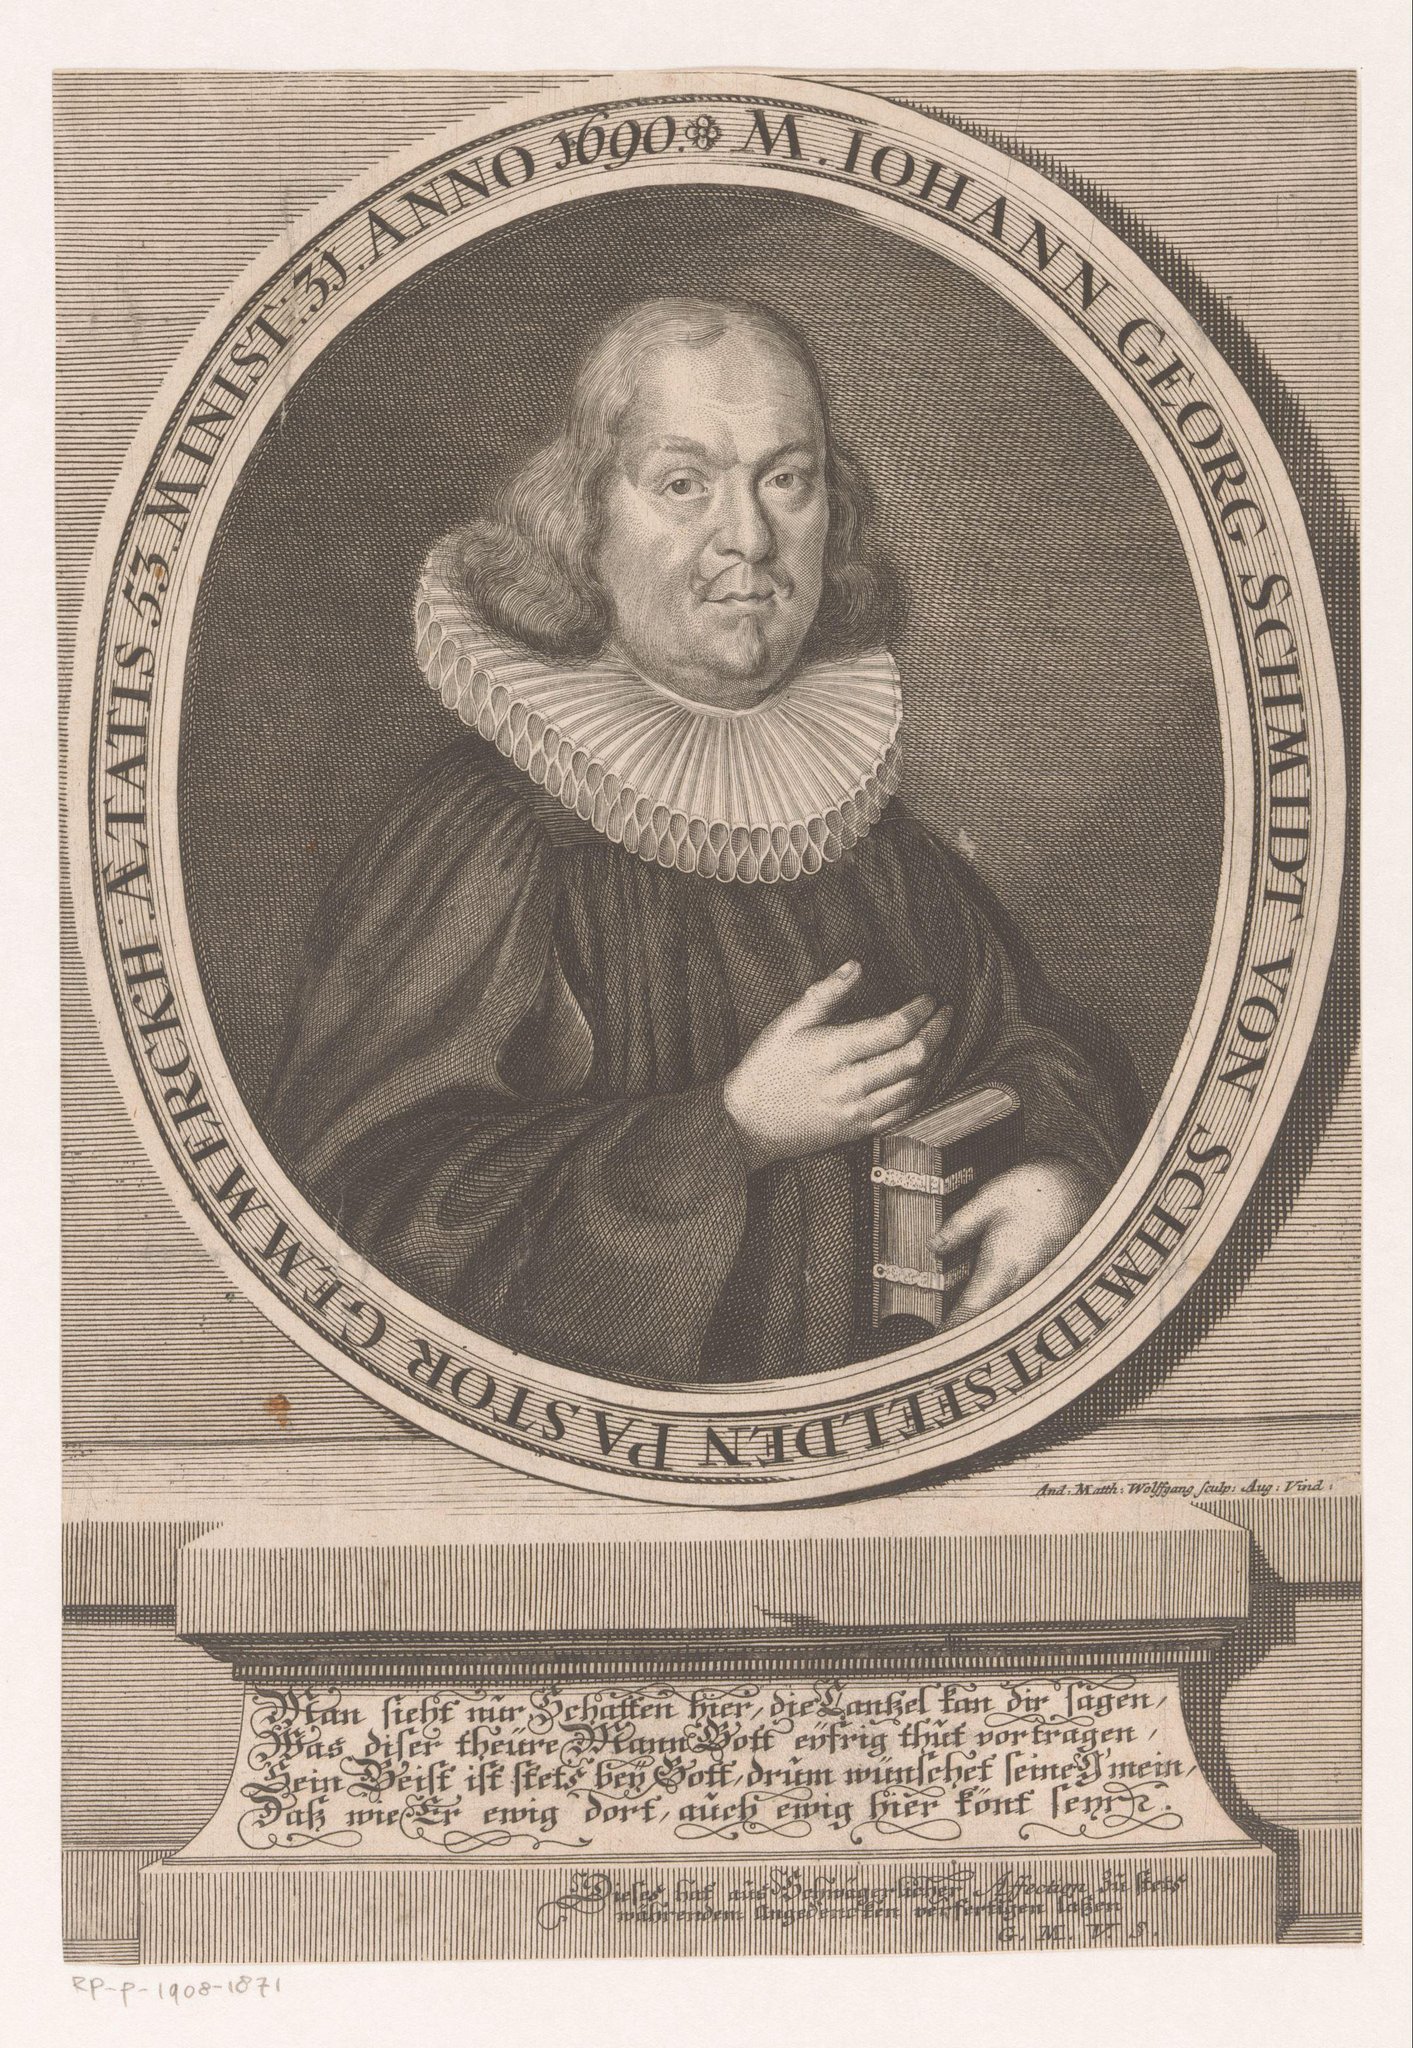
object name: print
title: Portret van Johann Georg Schmid von Schmidsfelden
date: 1670-1737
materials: paper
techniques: engraving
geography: augsburg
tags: historical persons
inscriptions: collector's mark: Lugt 2228